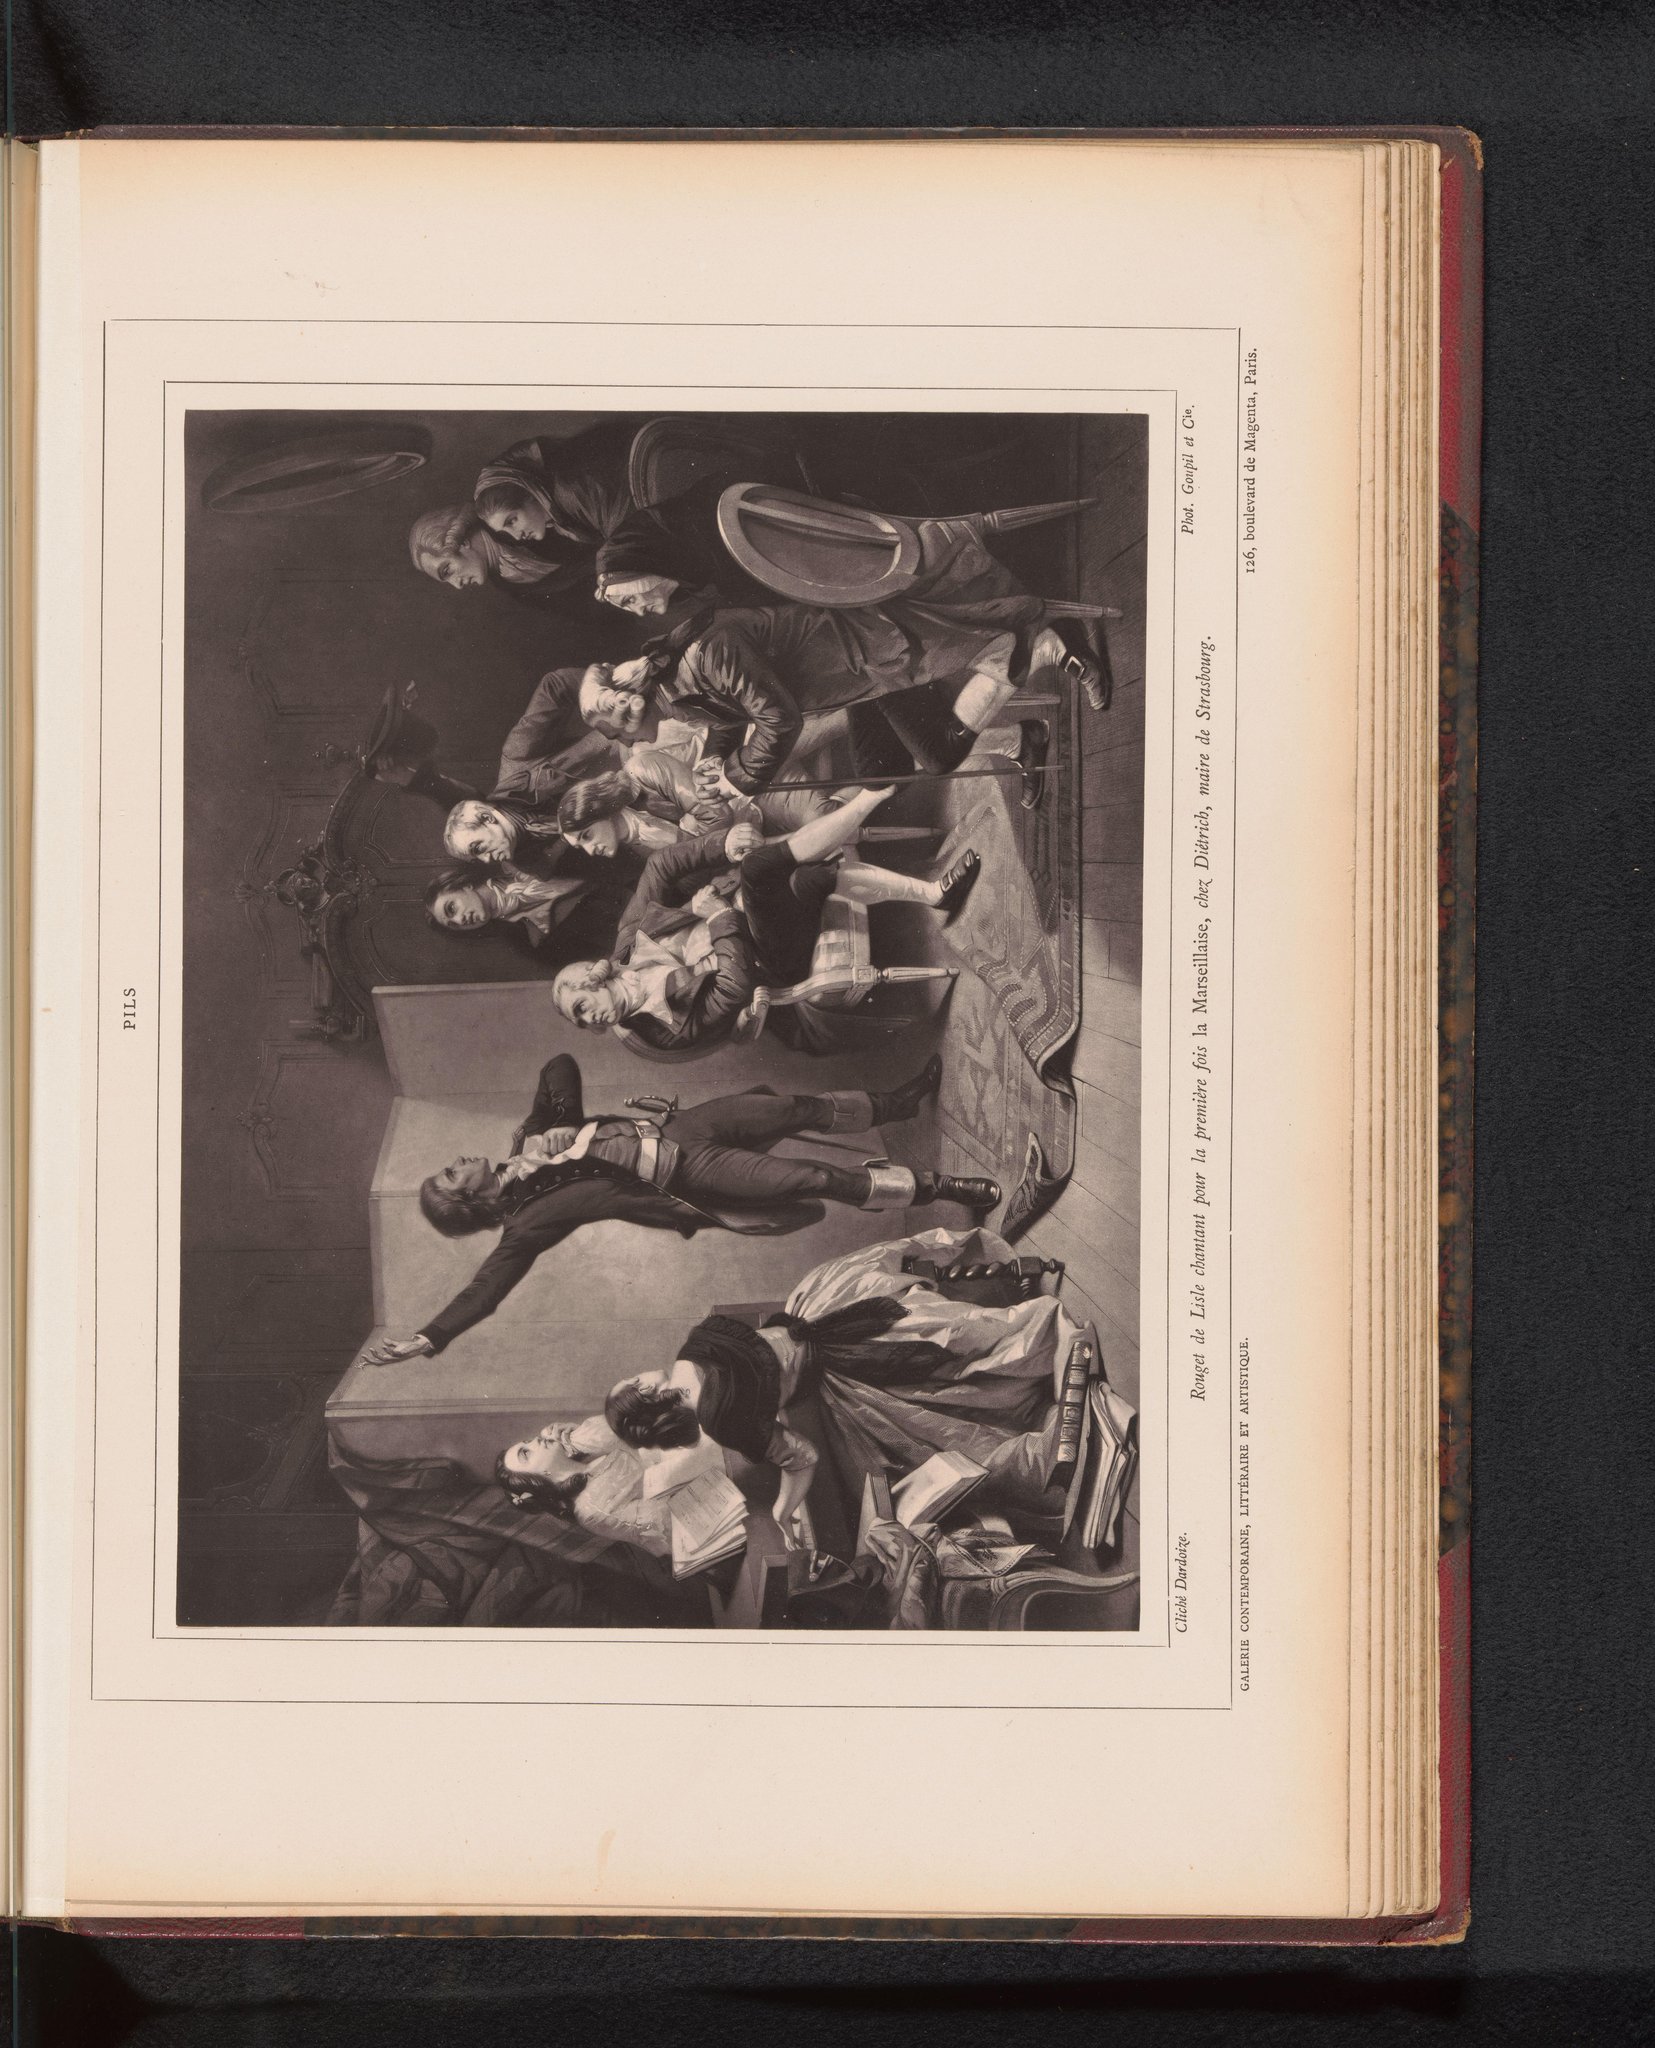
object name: reproduction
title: Reproductie van Rouget de Lisle chantant pour la première fois la Marseillaise, Chez Diétrich, maire de Strasbourg door Isidore Pils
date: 1872-1877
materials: paper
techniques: woodburytype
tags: vocal music, singing, painting, drawing and the graphic arts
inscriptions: inscription: ‘Pils/ Galerie Contemporaine, Littéraire, Artistque/ 126, boulevard de Magenta, Paris.’